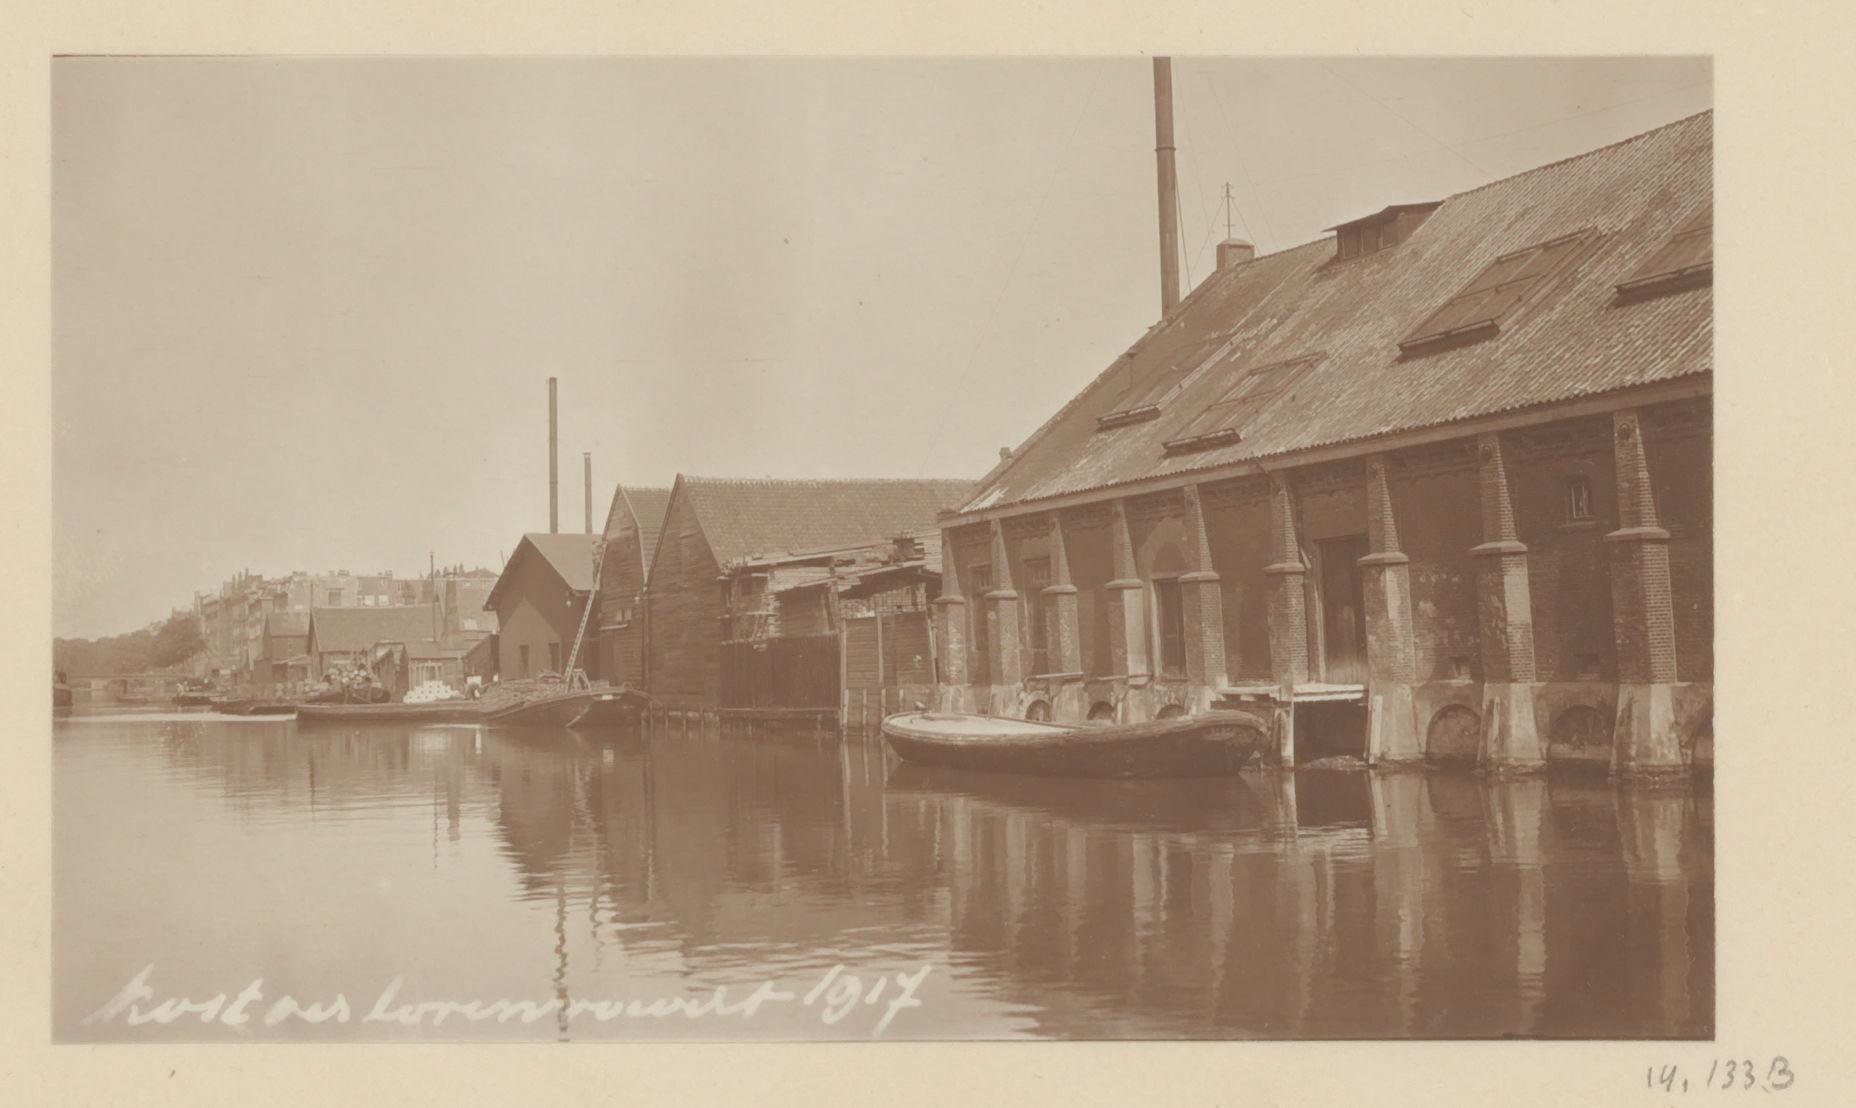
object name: photograph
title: Gezicht op de Kostverlorenvaart bij de De Wittenkade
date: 1917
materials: cardboard, paper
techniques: albumen print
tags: city-view in general; 'veduta', canal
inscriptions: inscription: ‘De Wittenkade (Kostverlorenvaart) / in 1917. / April 1920. / Geschenk v/d Heer J. van Eck.’, collector's mark: ‘14.133AB’ Lugt 1641b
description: Onderwerpsrubriek binnen de Atlas Amsterdam: Waal (Kromme en Oude), Walenpleintje, Warmoesgracht, Warmoesstraat, Waterlooplein, Westerdoksdijk, Westermarkt, Weteringschans, Willemspark, Willemsstraat, Wittenburg, Wittenkade (de), Wittenstraat (de).